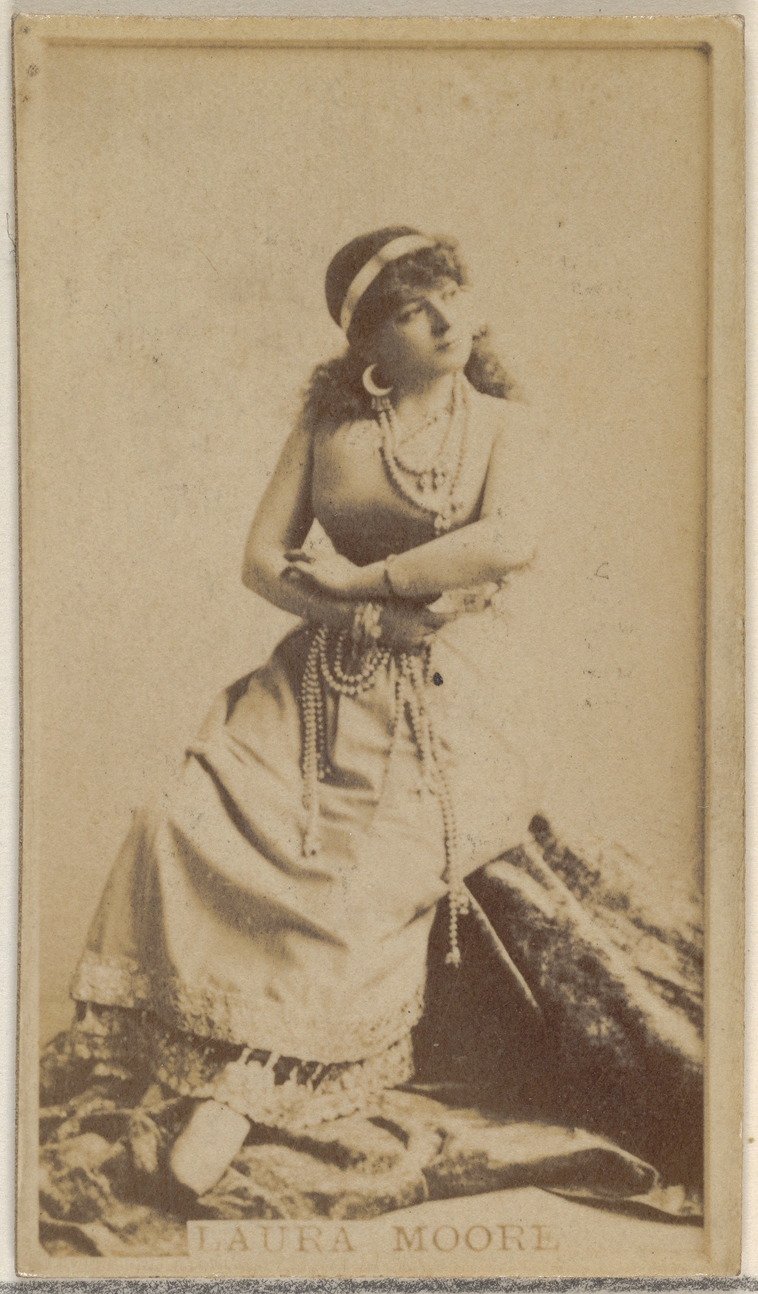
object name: photograph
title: Laura Moore, from the Actors and Actresses series (N45, Type 8) for Virginia Brights Cigarettes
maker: allen & ginter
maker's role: publisher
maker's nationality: american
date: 1888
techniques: albumen silver print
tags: portraits,women,actresses